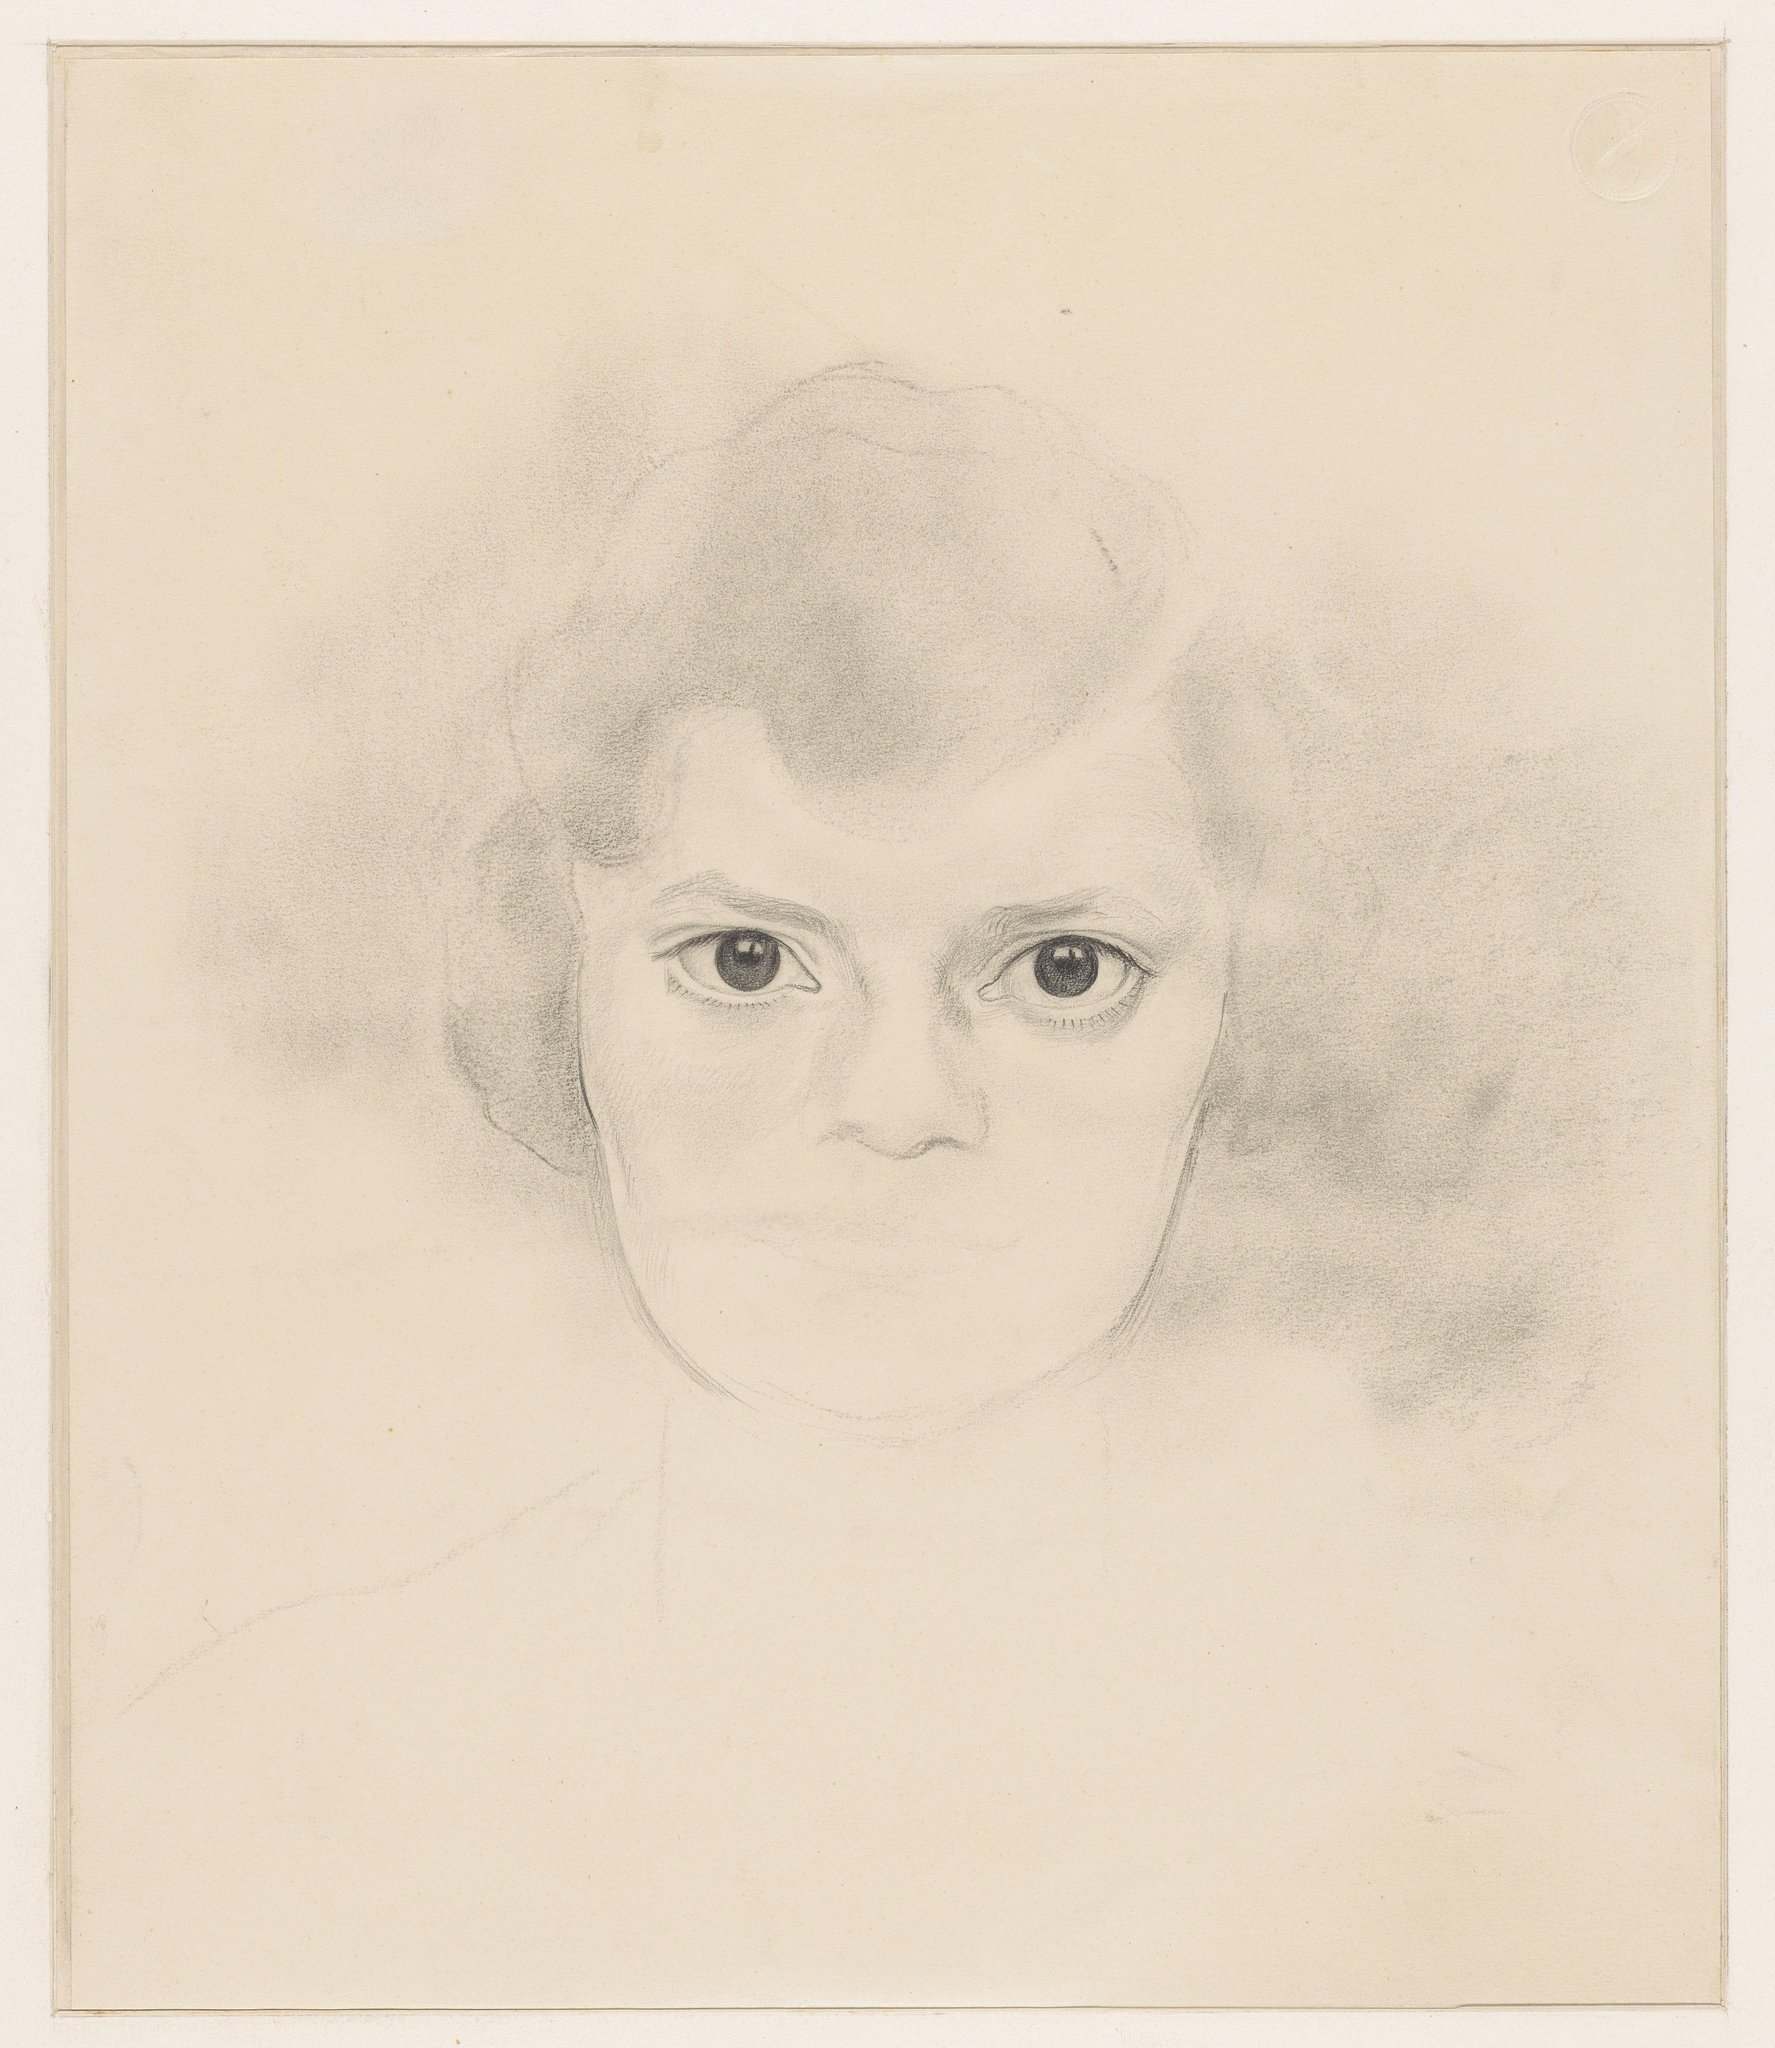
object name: drawing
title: Ogen van een meisje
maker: theo van reijn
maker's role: draughtsman, print maker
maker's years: 1884-1954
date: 1894-1954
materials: chalk, paper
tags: eyes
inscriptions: check stamp